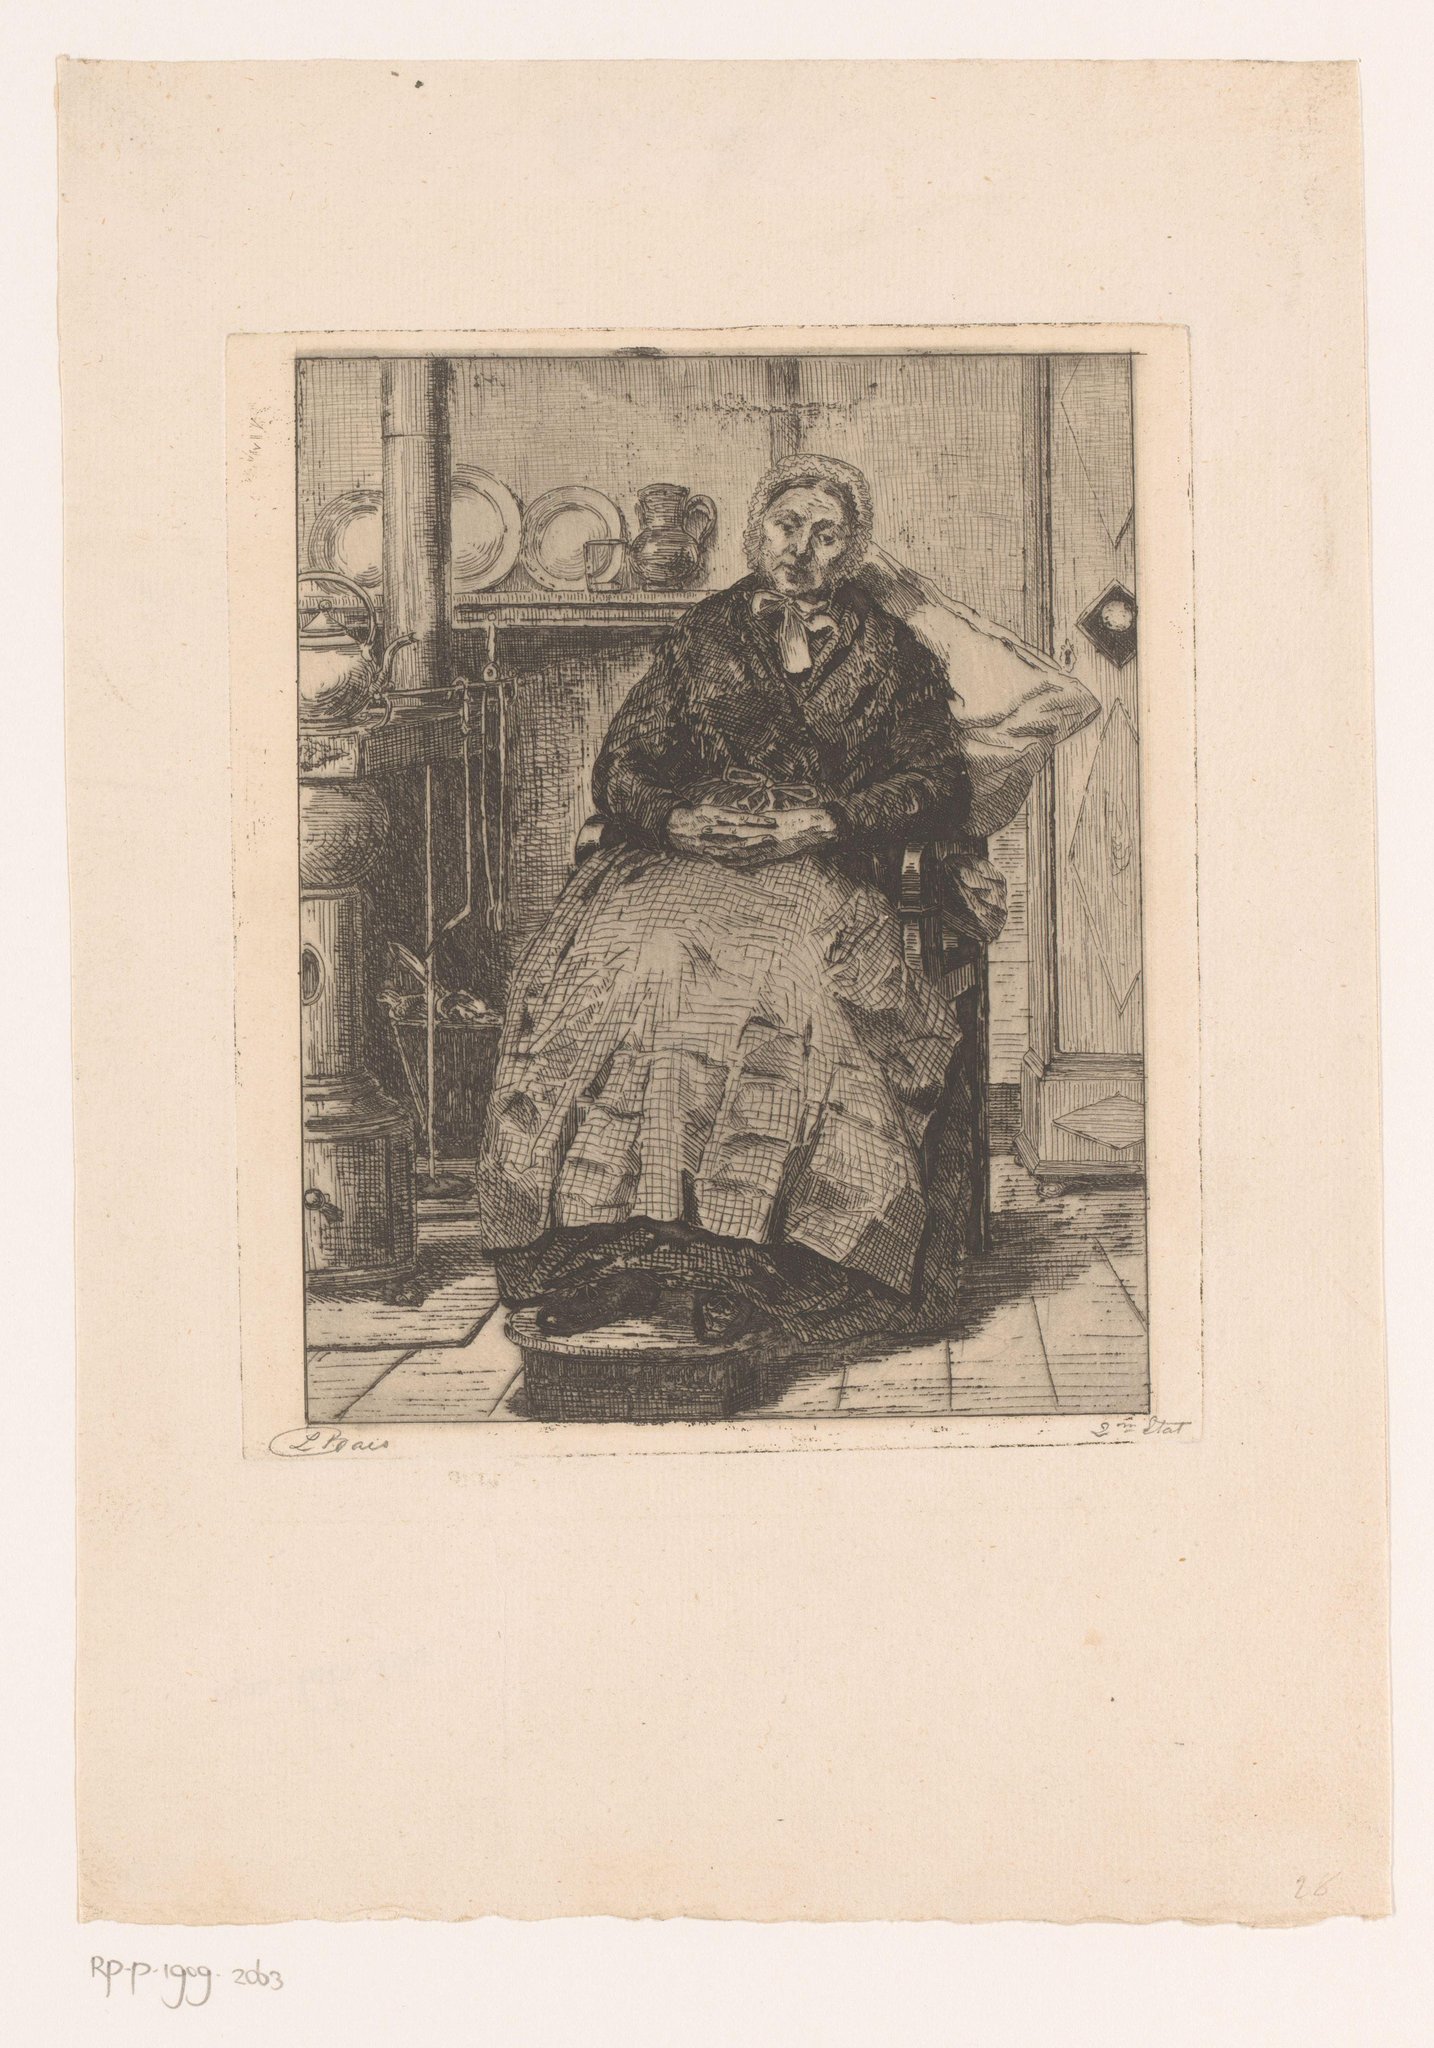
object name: print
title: Oude dame zit comfortabel naast de kachel in de keuken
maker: lionel oscar baes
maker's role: print maker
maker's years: 1839-1913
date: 1849-1909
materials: paper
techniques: drypoint, etching, intaglio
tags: old woman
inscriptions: collector's mark: Lugt 2228, annotation: ‘2eme Etat’